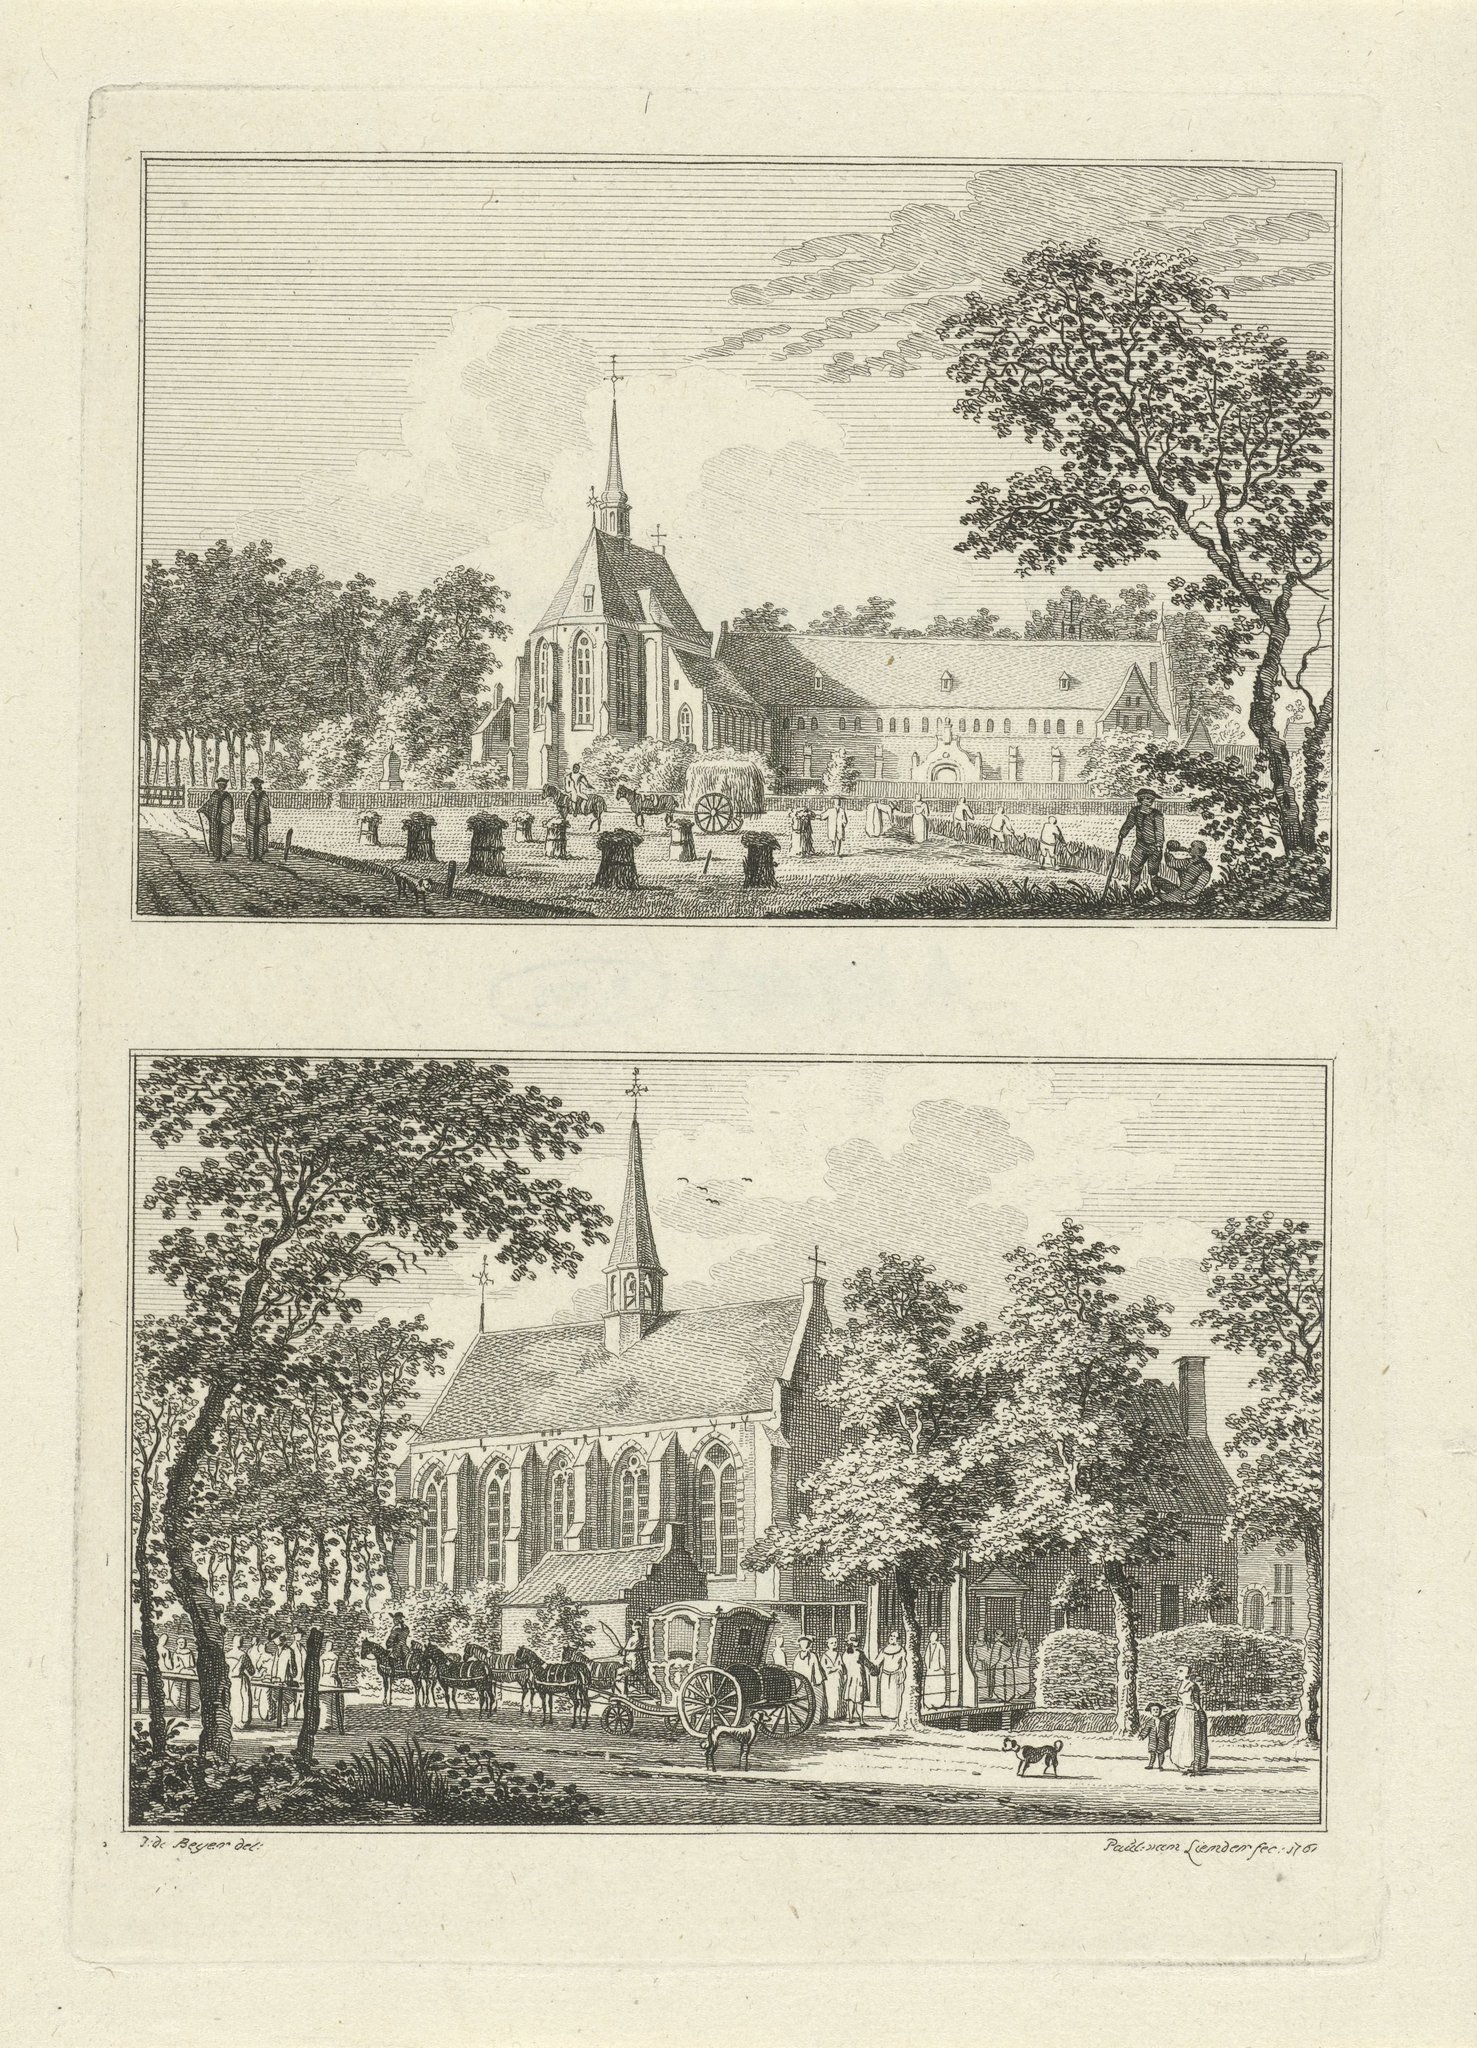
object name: print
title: Klooster Gaasdonk bij Goch en klooster Mariënwater te Weeze, 1743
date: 1761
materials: paper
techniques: etching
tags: abbey, monastery, convent ~ roman catholic church, church (exterior)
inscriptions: collector's mark: Lugt 2228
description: Twee voorstellingen van één plaat. Gezichten op het klooster Gaasdonk in de Duitse stad Goch (boven) en klooster Mariënwater te Weeze (onder). De prent maakt deel uit van een 100-delige serie met gezichten op dorpen en steden te Kleef.